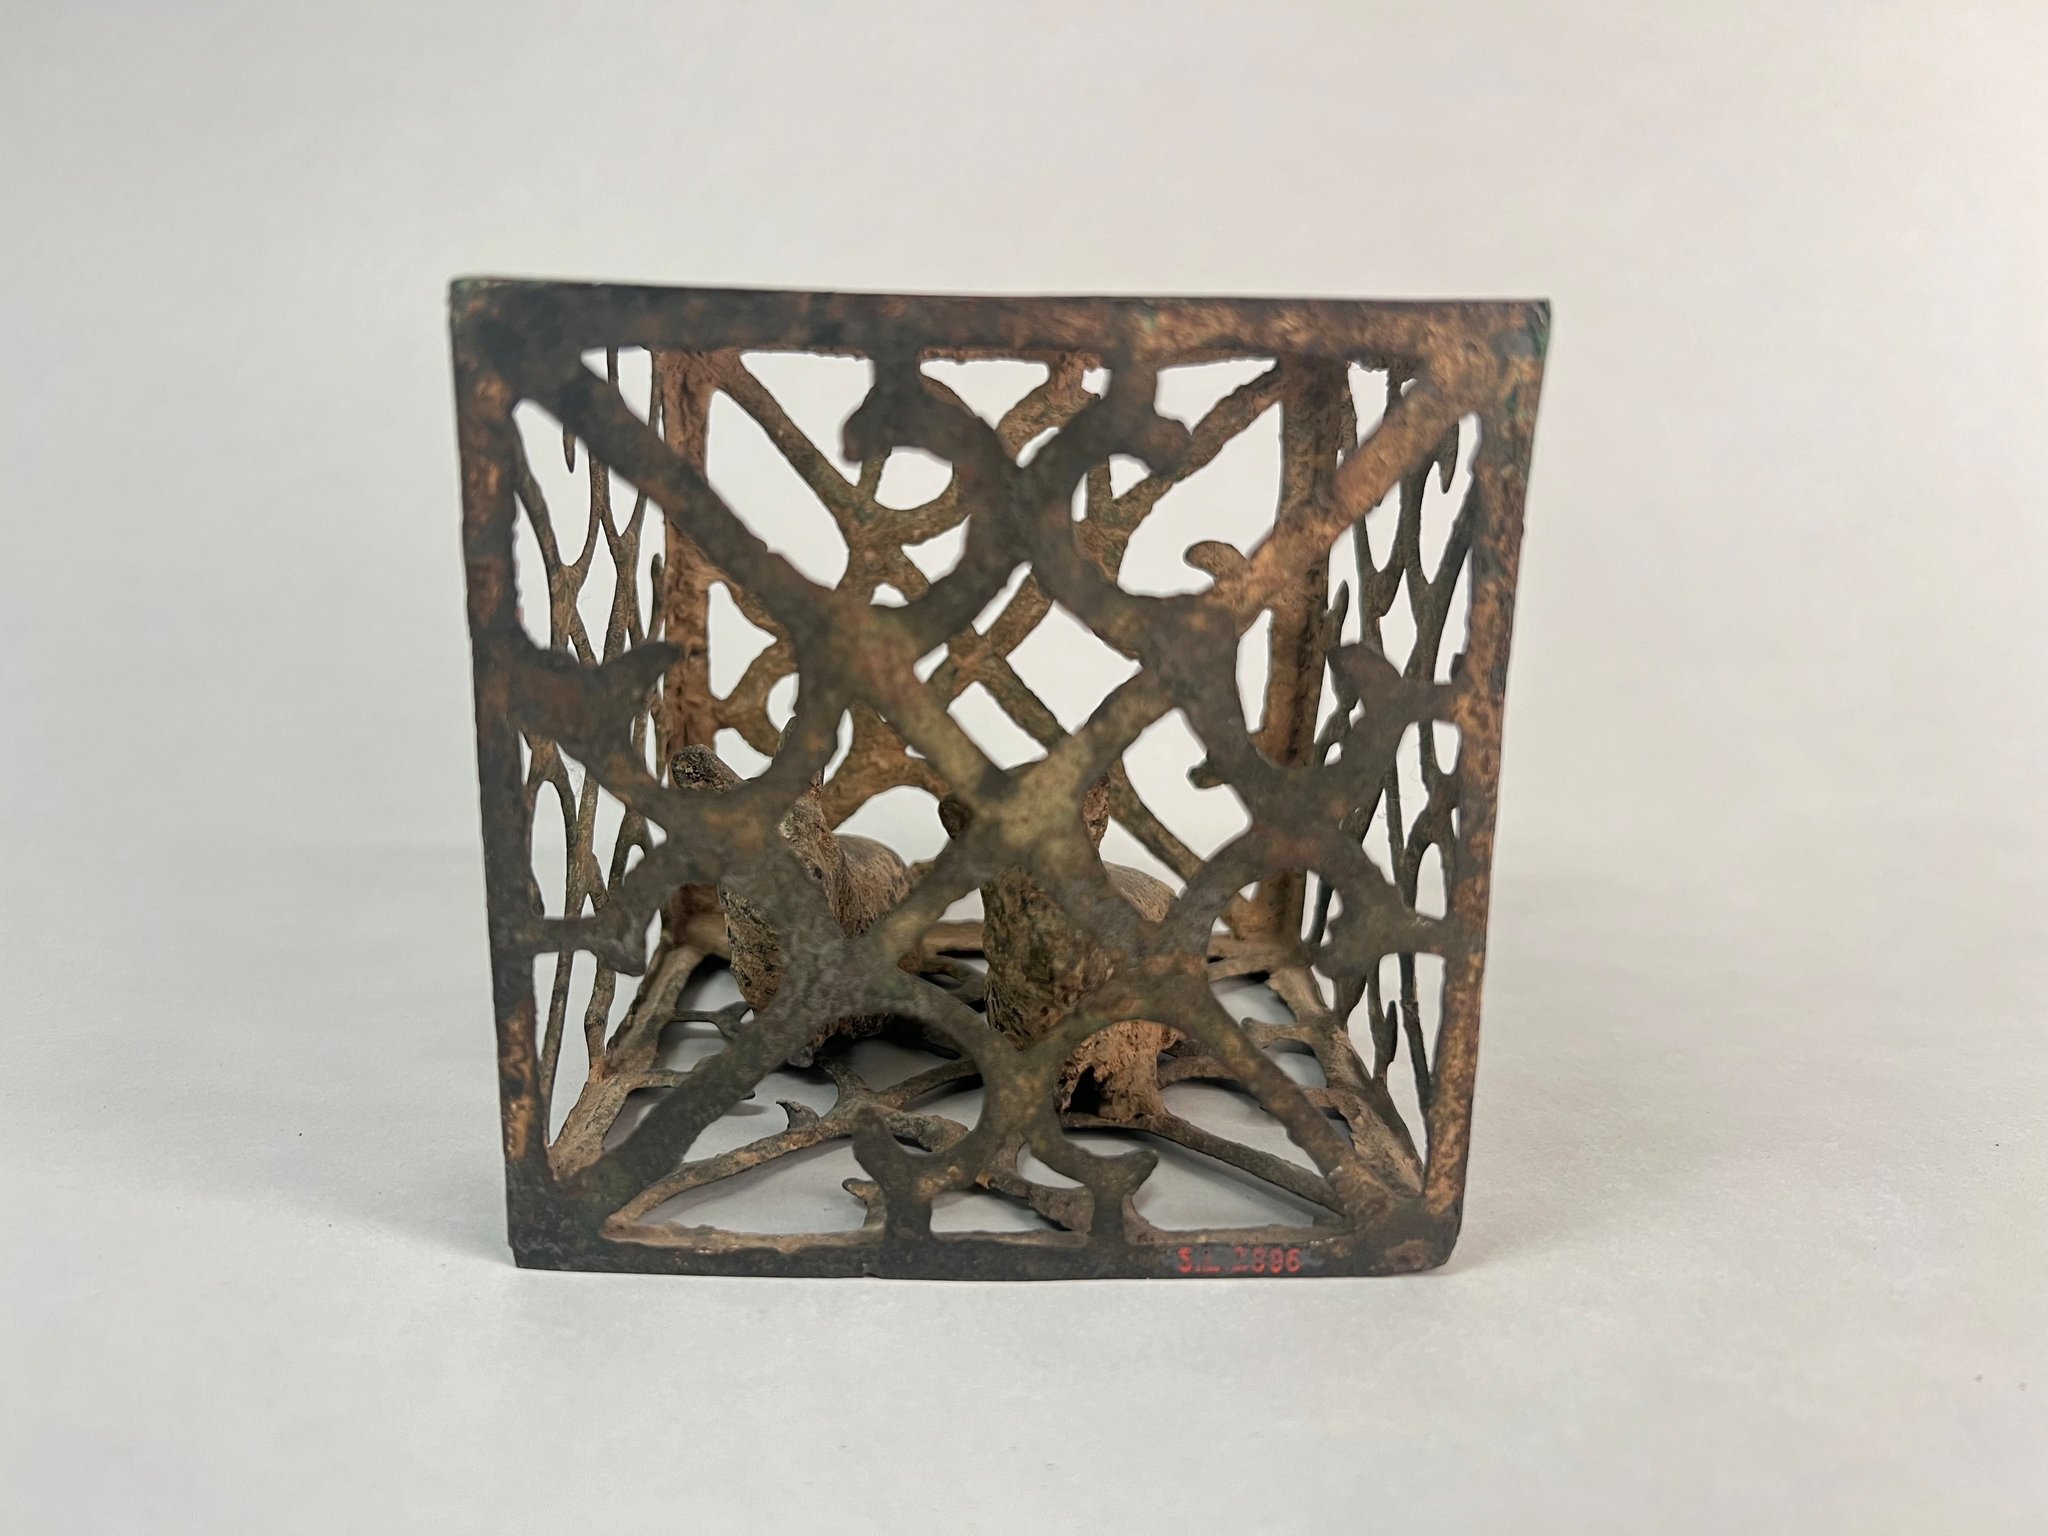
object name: cage with rabbit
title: Cage with Two Rabbits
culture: chinese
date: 206 BCE-220 CE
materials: bronze